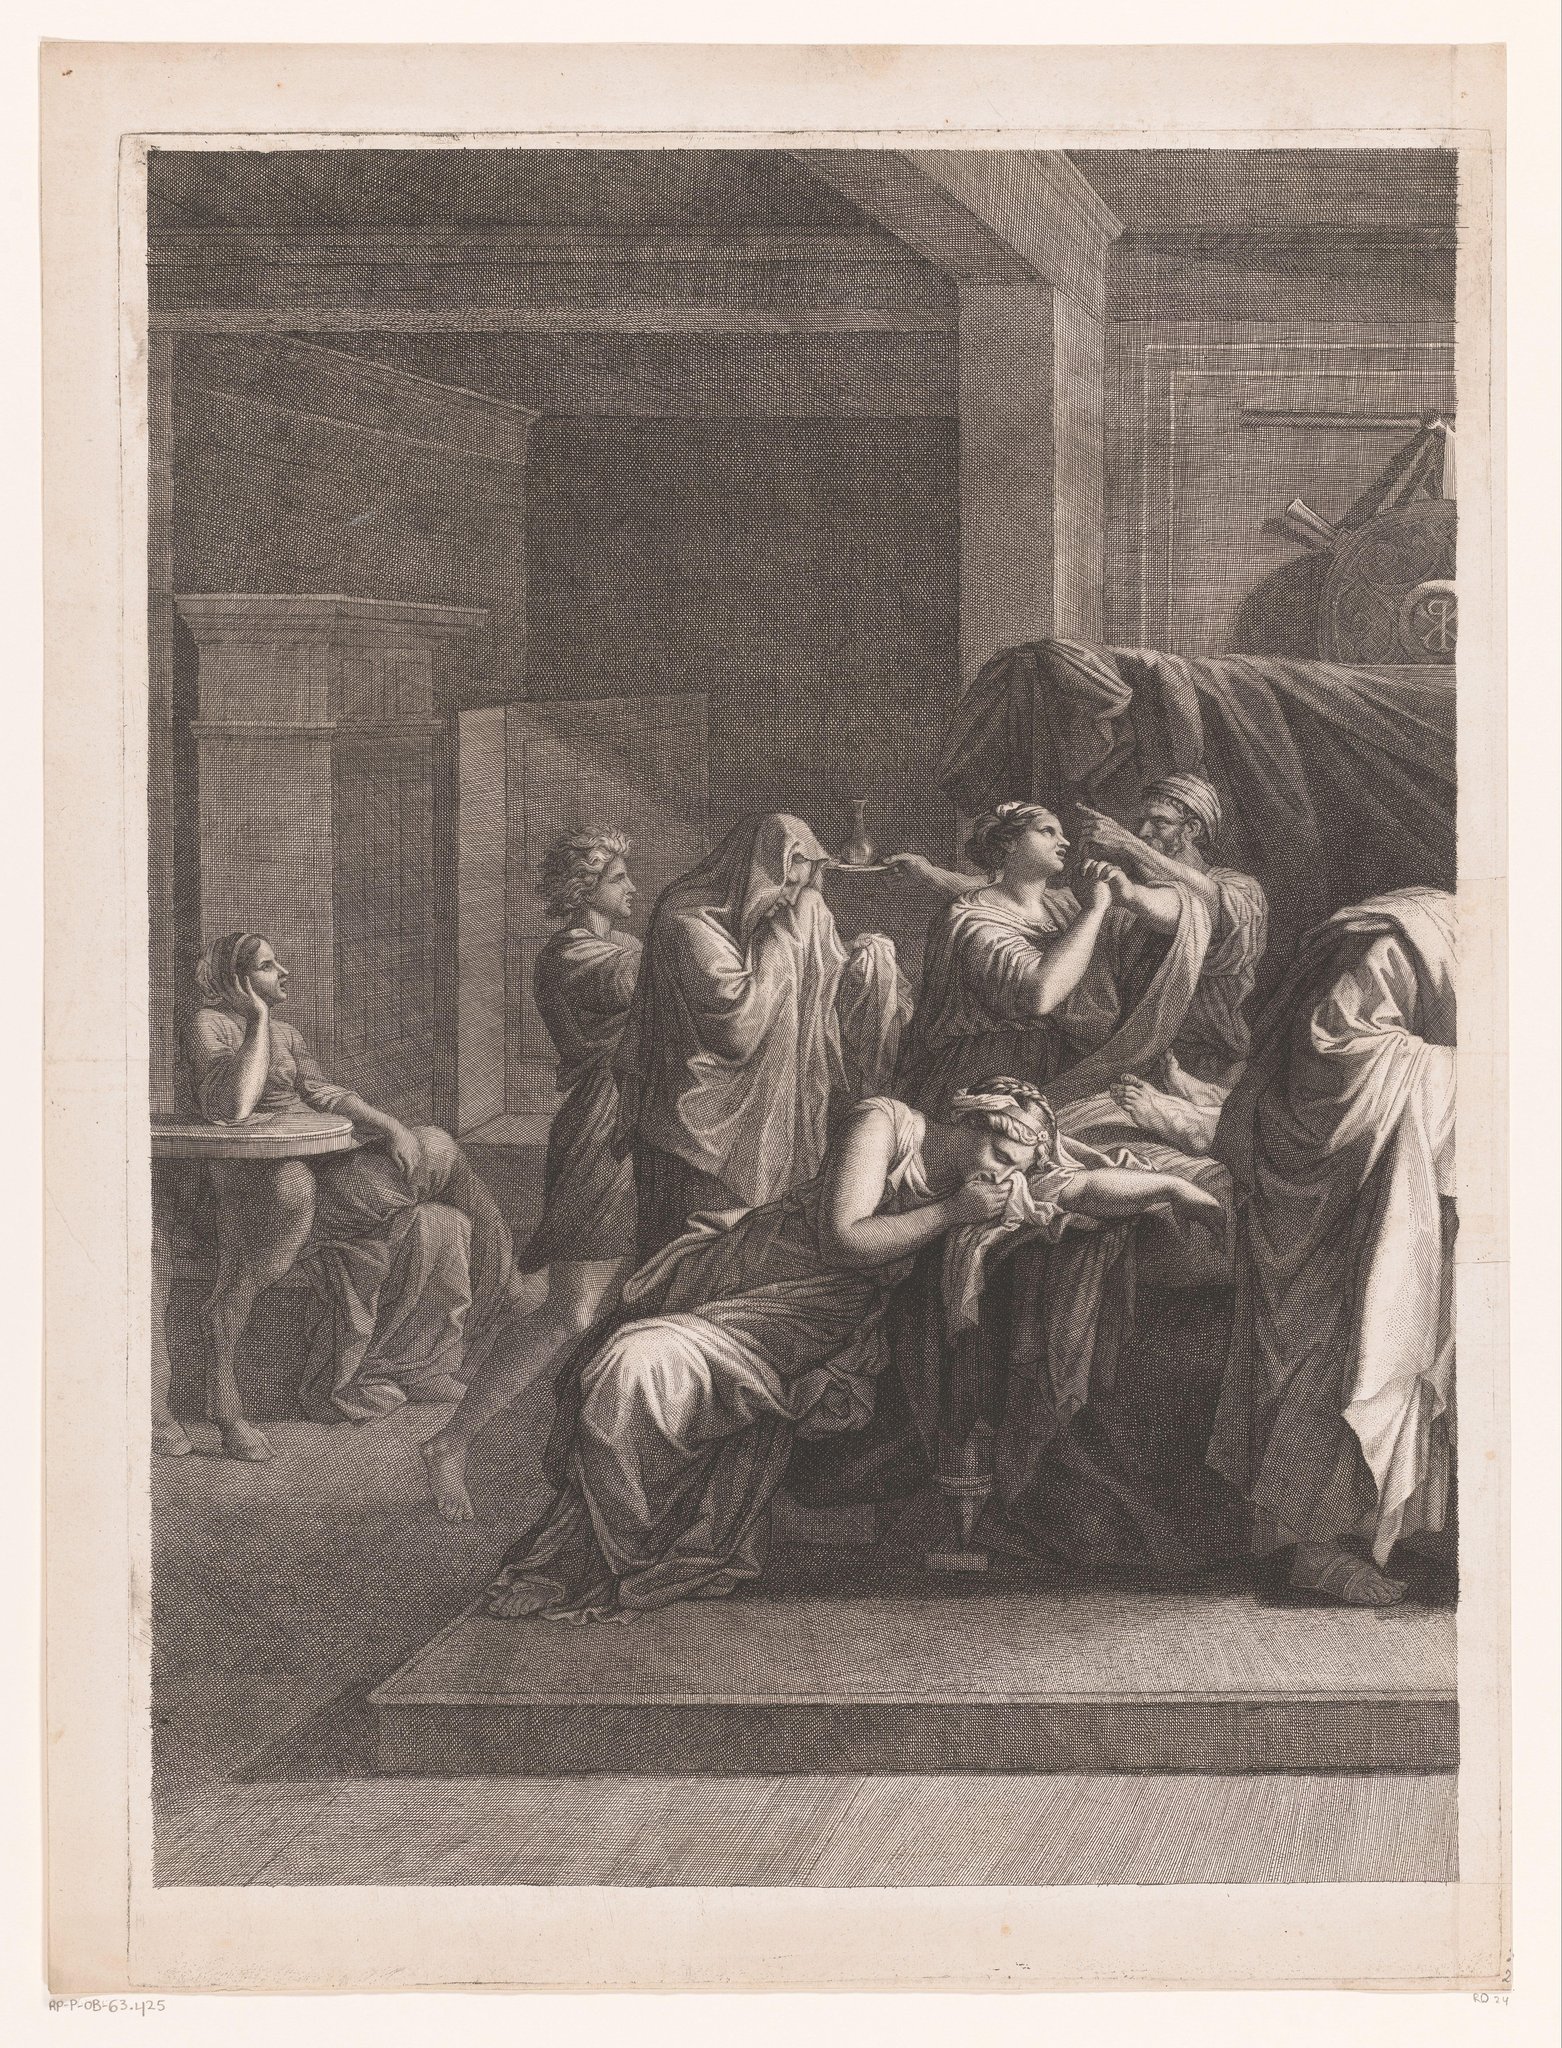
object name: print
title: Heilig Oliesel (linker deel)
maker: jean pesne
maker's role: print maker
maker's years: 1623-1700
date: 1633-1700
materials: paper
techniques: etching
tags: extreme unction ~ the last of the seven sacraments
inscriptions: collector's mark: Lugt 240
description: Prent maakt deel uit van een ongenummerde serie van zeven prenten.